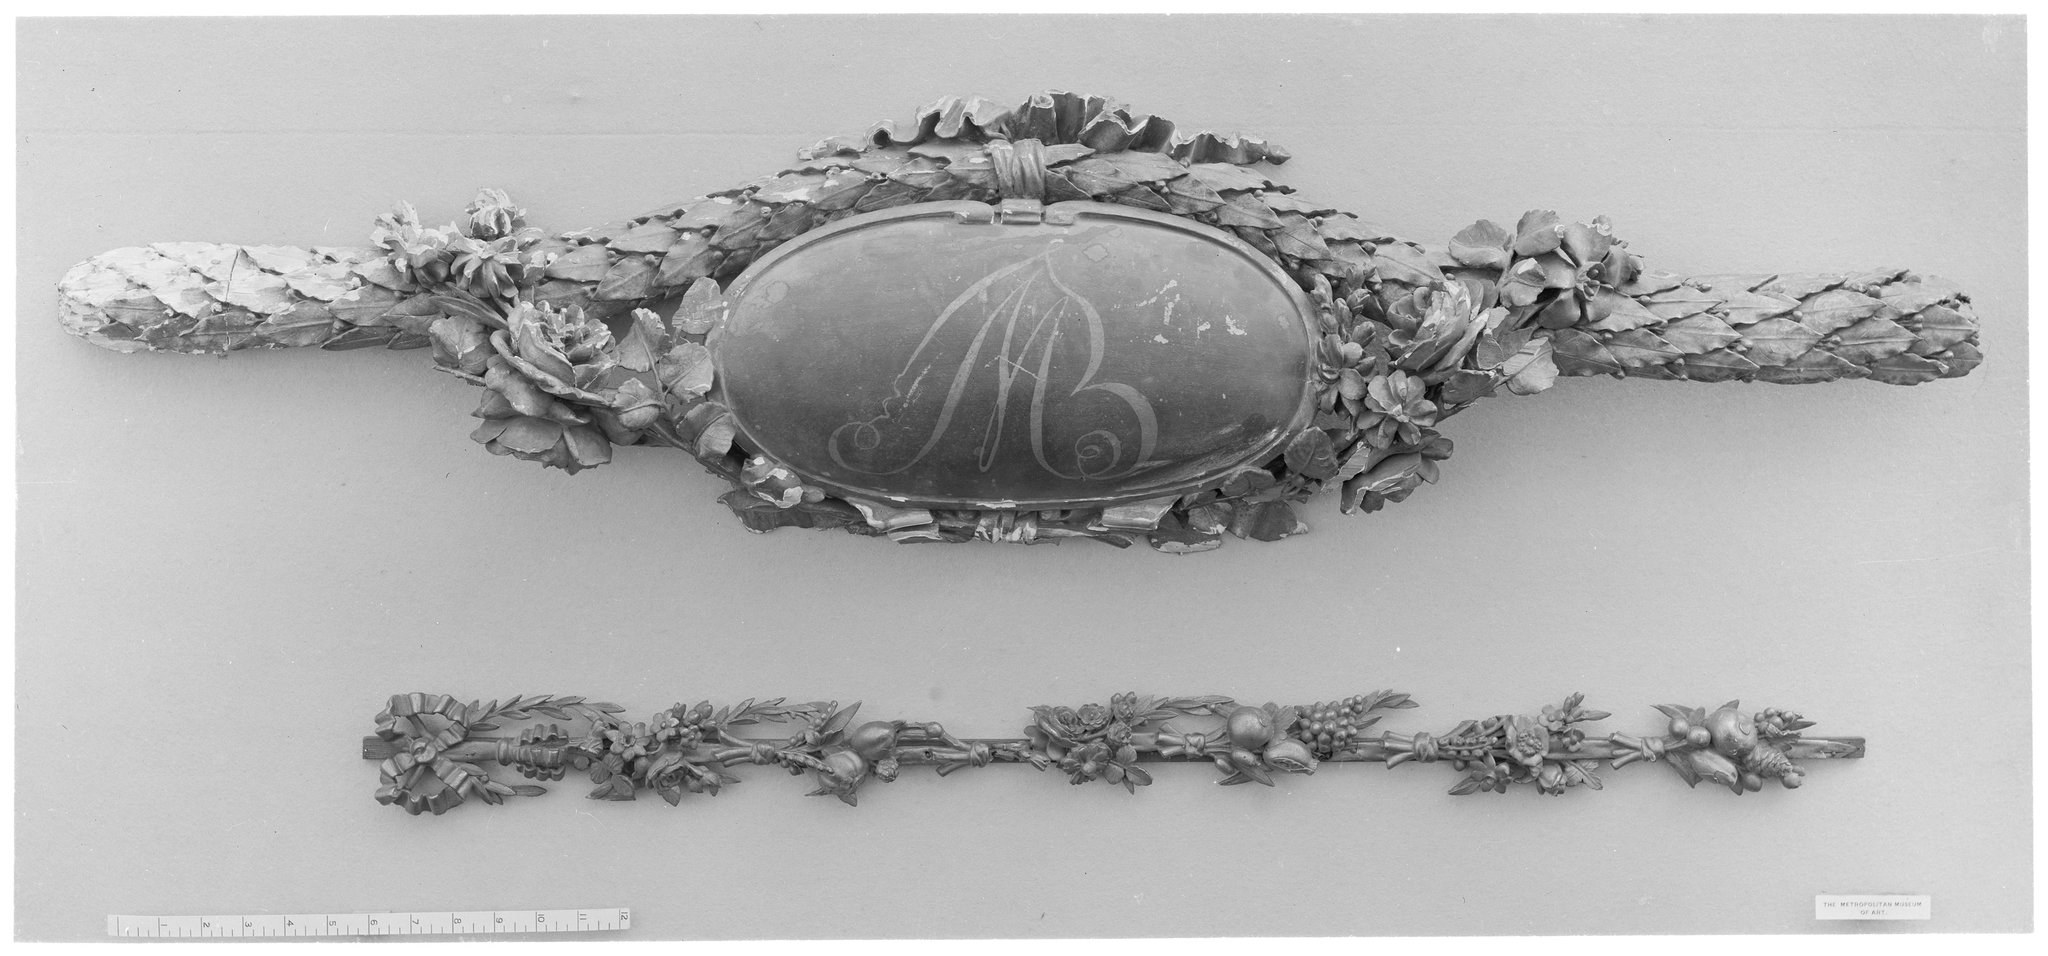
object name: frame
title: Frame (Fronton)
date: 1701-1800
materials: gilt, wood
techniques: carving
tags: grapes,flowers,leaves,insignia